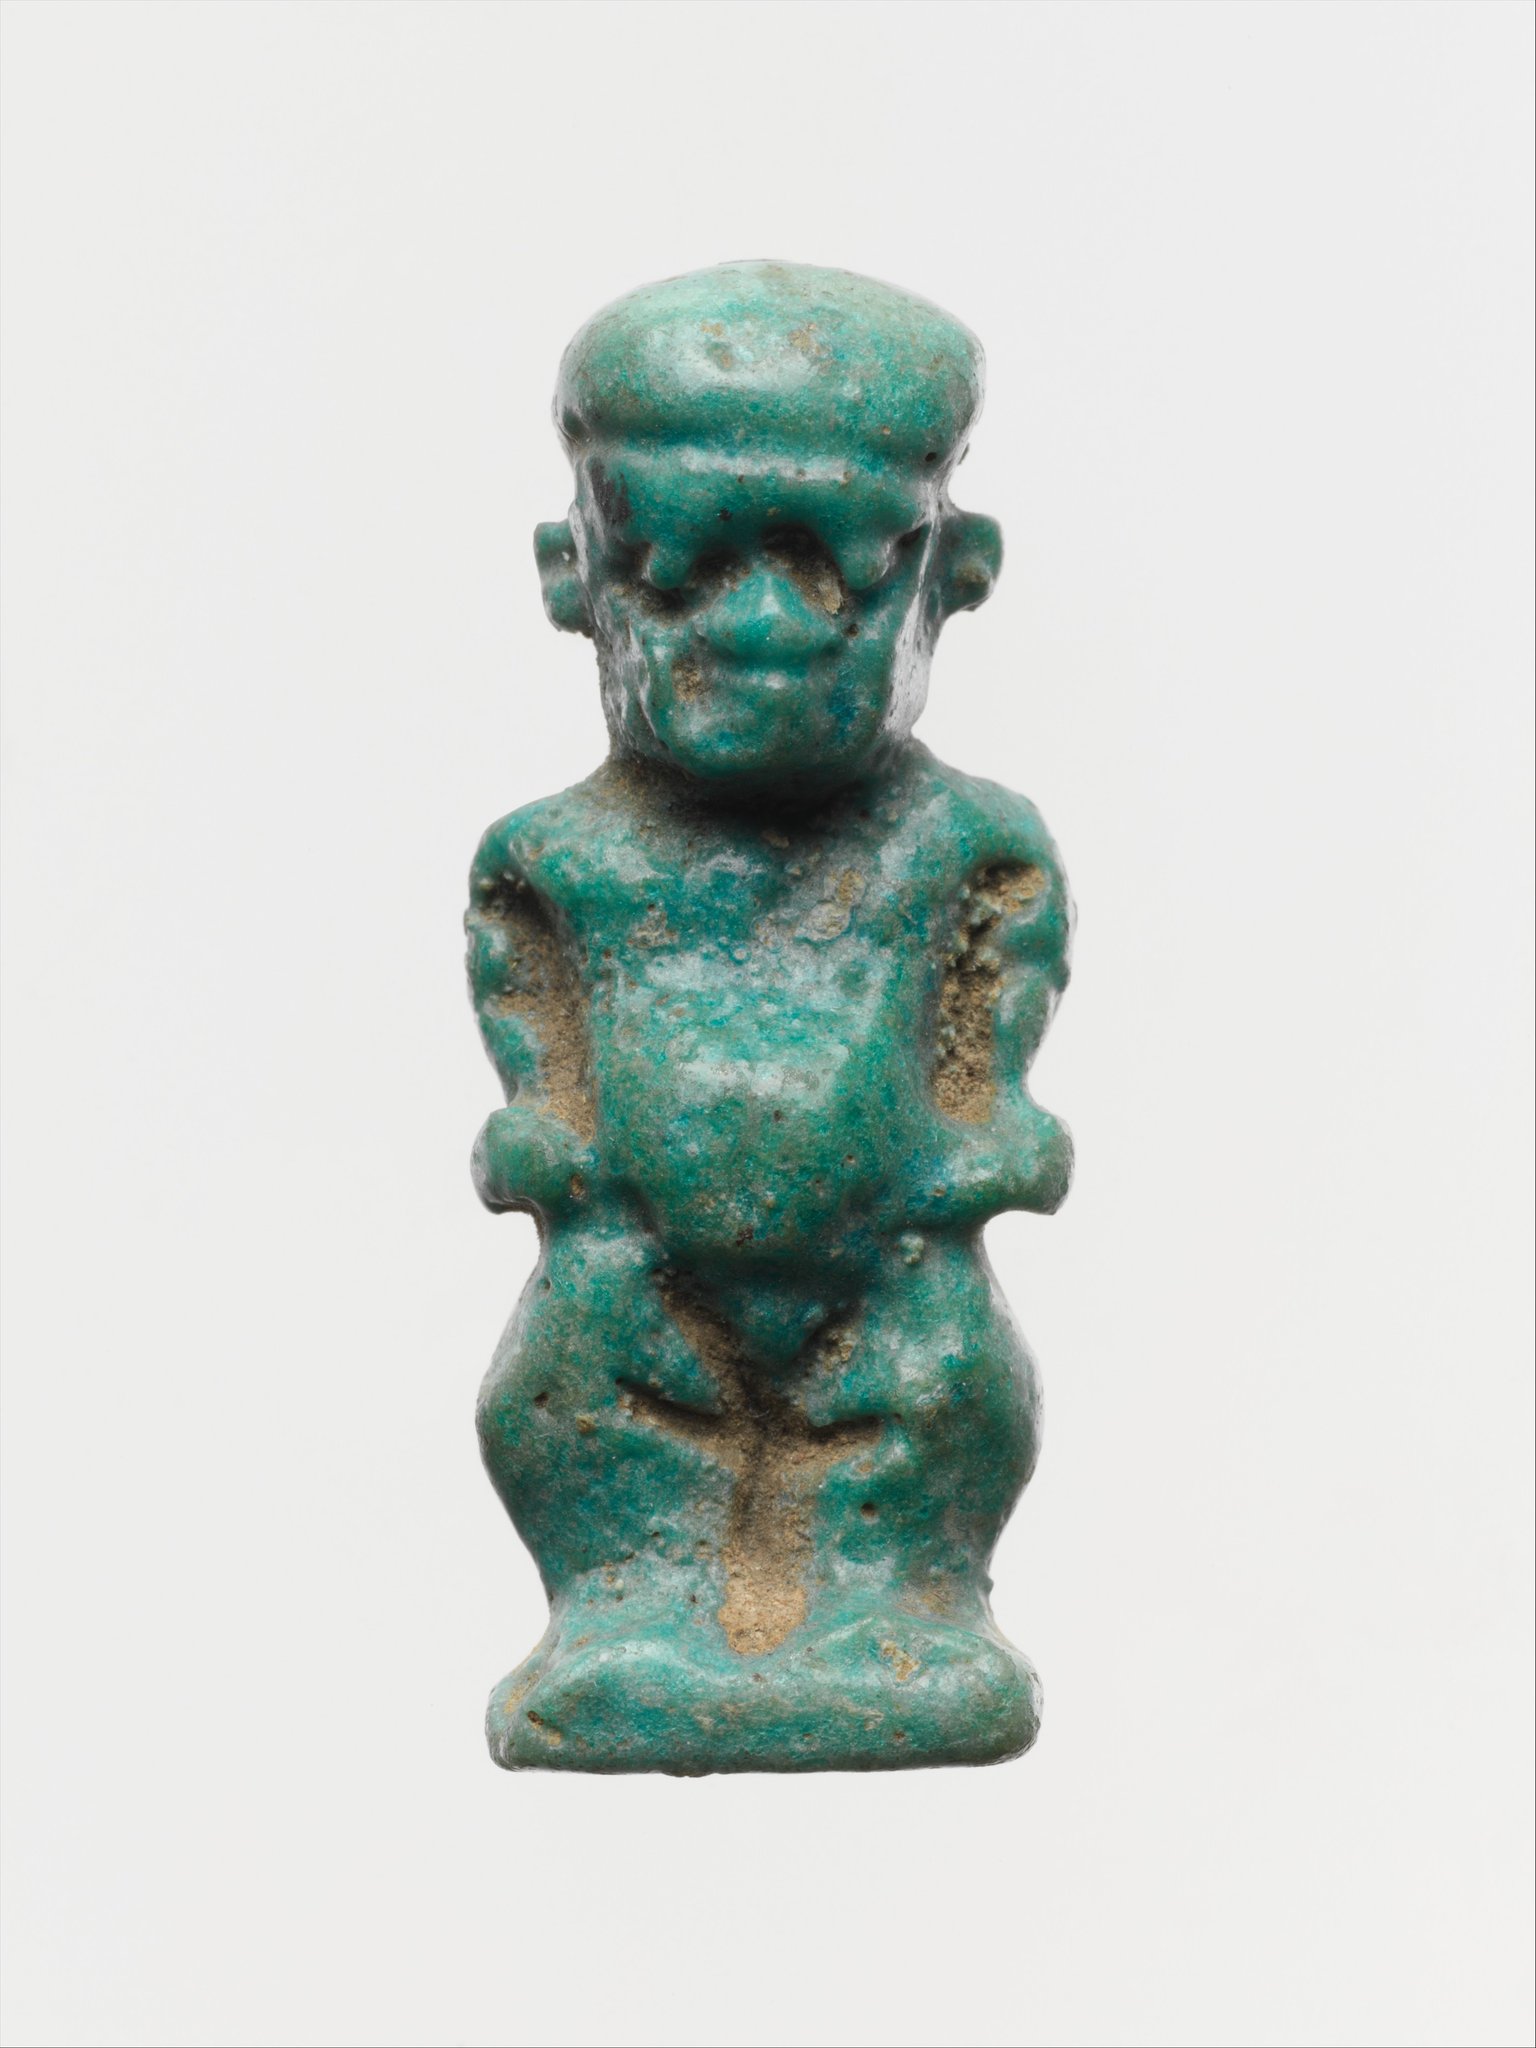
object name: amulet, ptah seker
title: Faience amulet in the form of the dwarf god Pataikos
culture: egyptian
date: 1090-900 BCE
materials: clay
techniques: glazing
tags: male nudes,gods